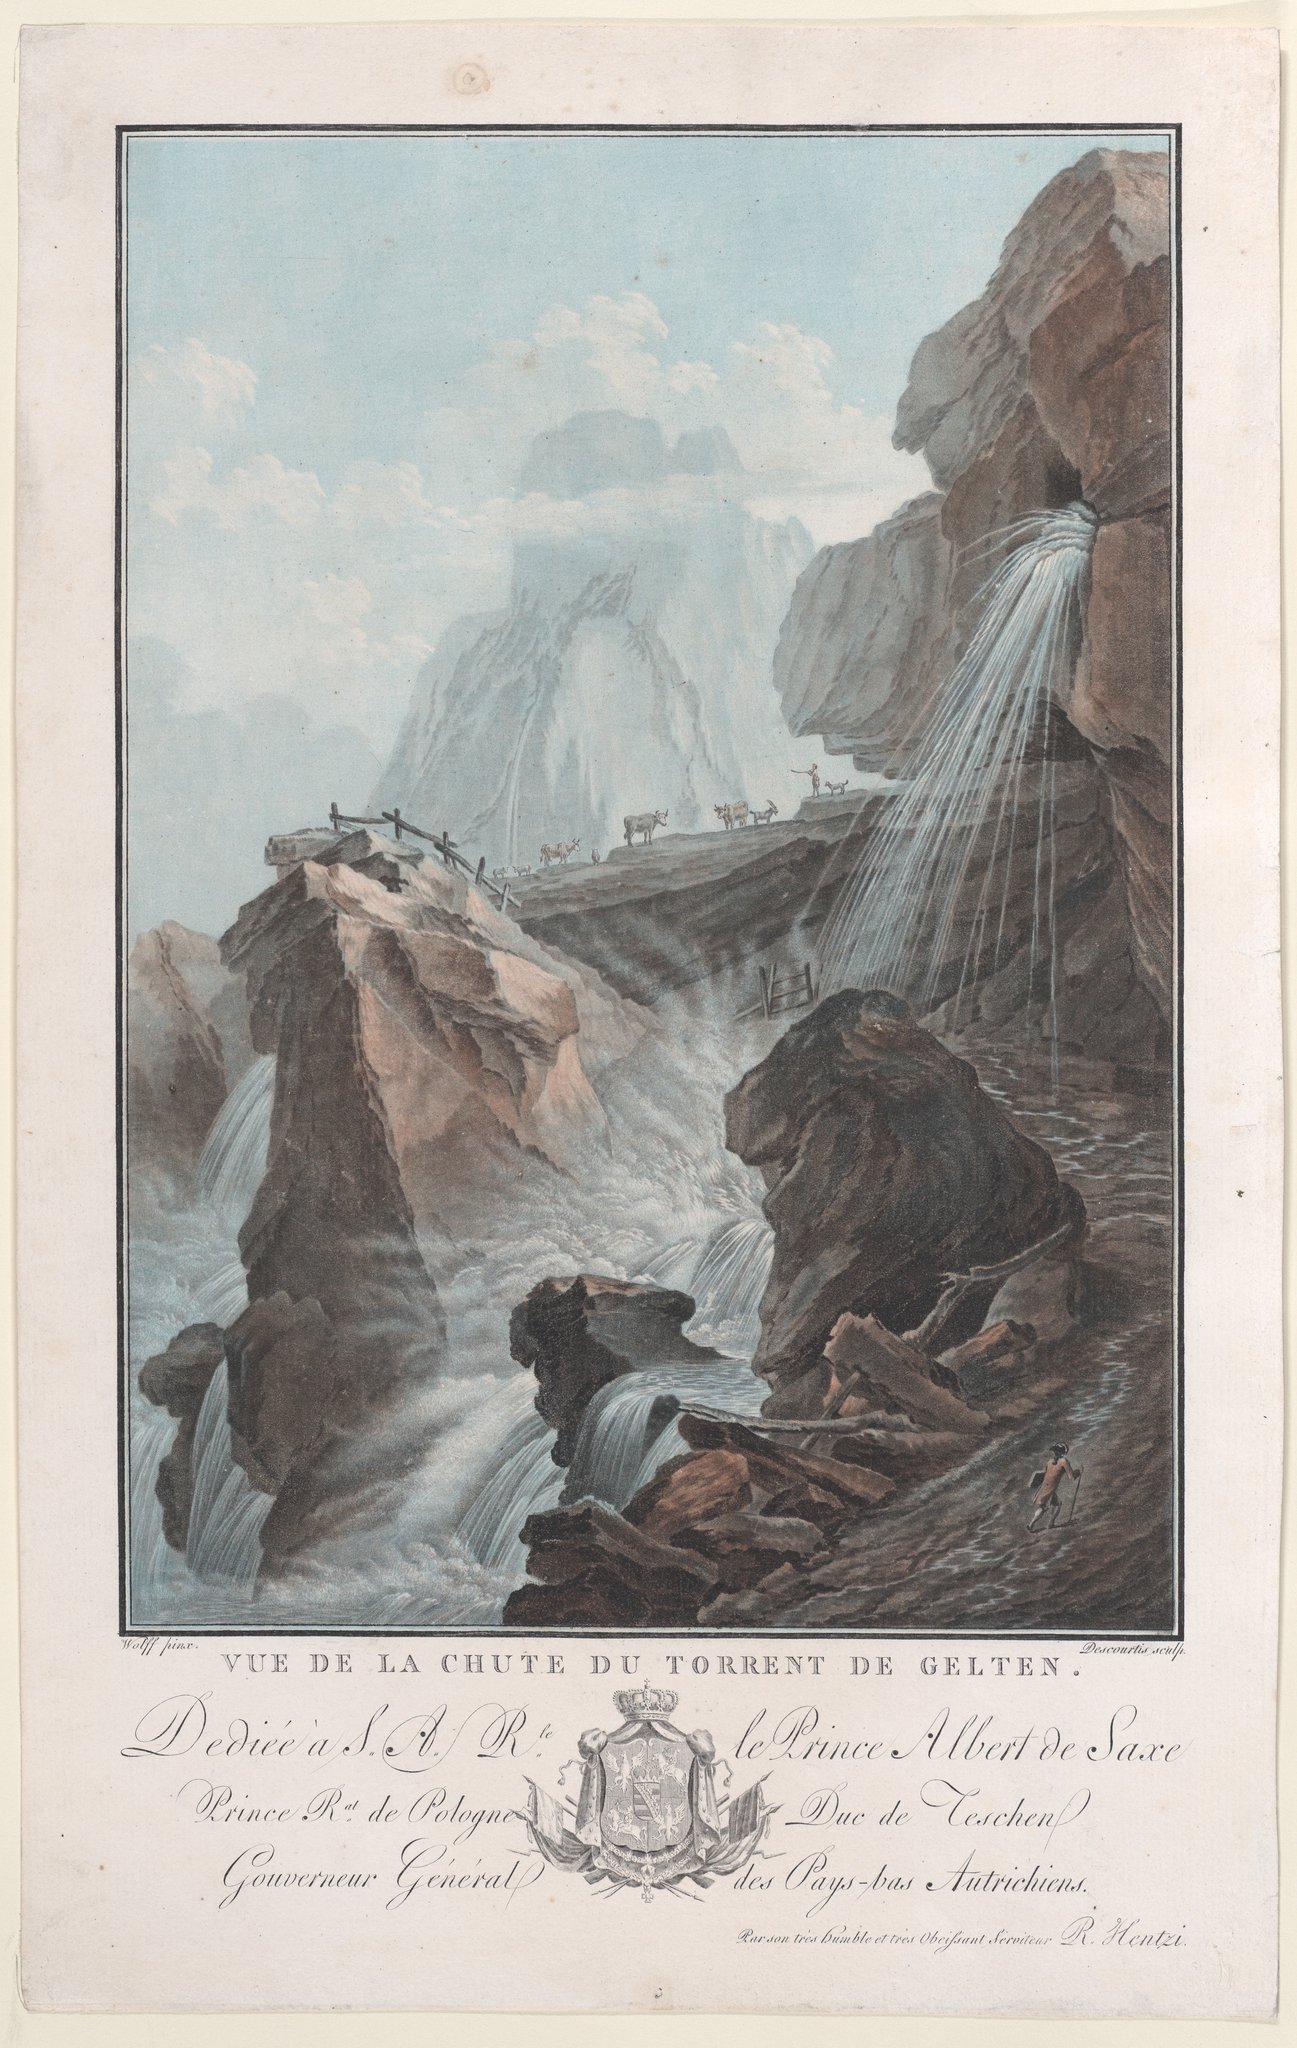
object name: print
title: Vue de la chute du torrent de Gelten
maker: charles melchior descourtis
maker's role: artist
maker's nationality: french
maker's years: 1753-1820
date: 1785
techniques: aquatint, engraving, etching